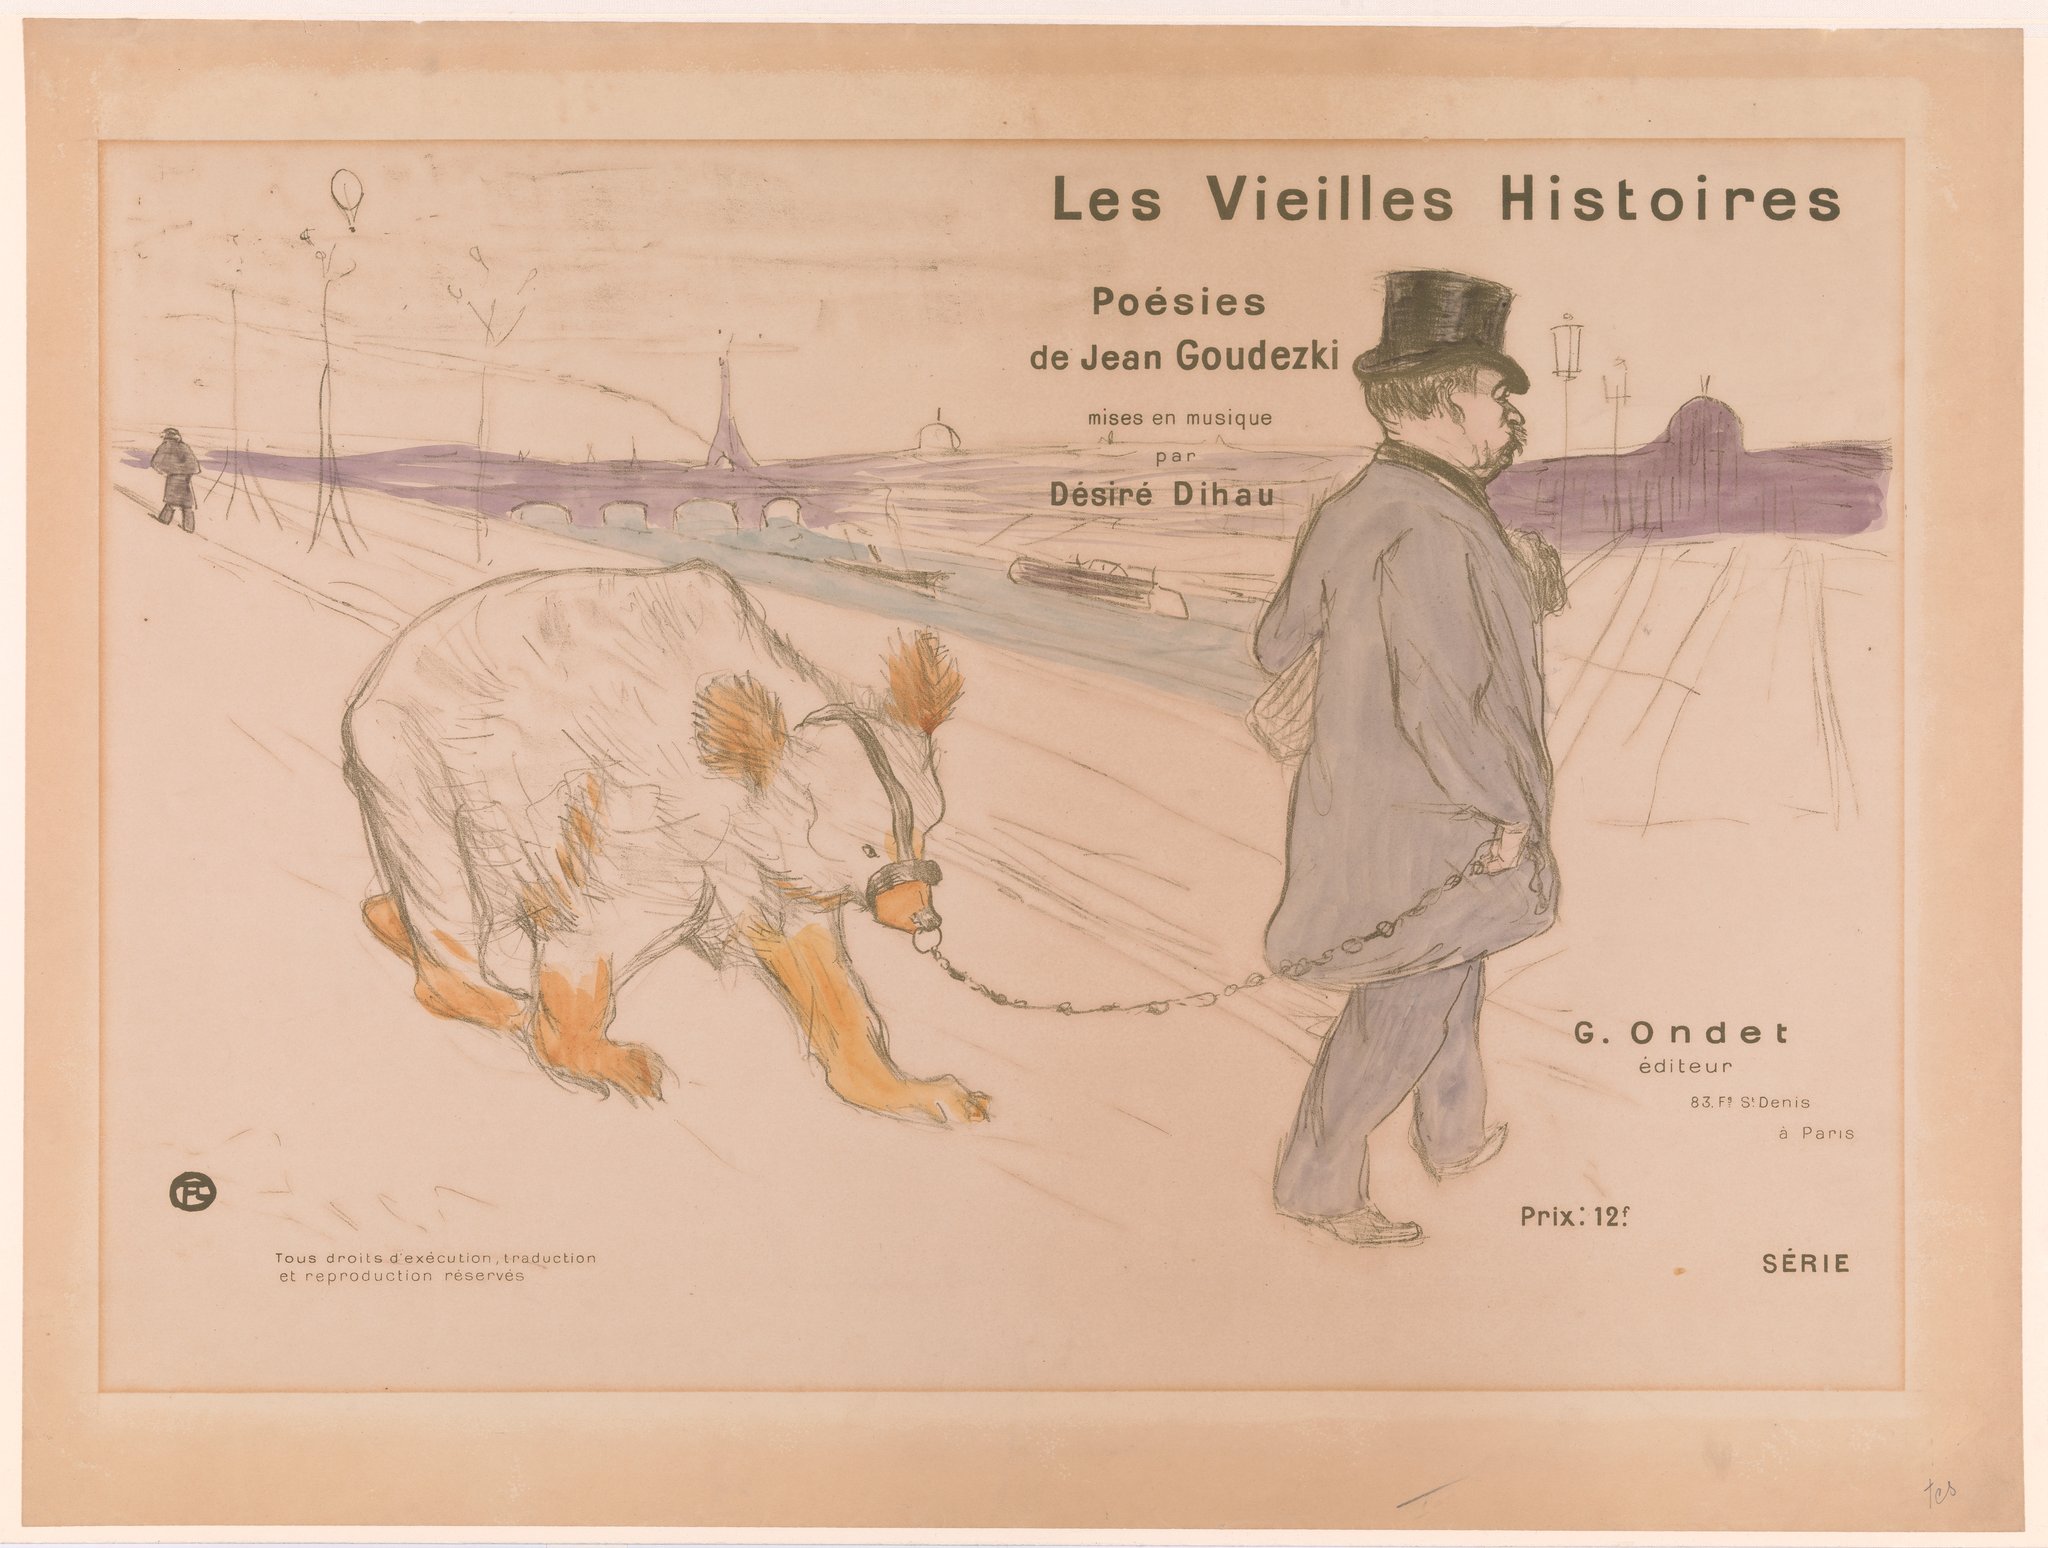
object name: print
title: Cover Design for "Les Vieilles Histoires"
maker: henri de toulouse-lautrec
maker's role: artist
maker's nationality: french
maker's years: 1864-1901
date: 1893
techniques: hand coloring, lithograph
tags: bears,men